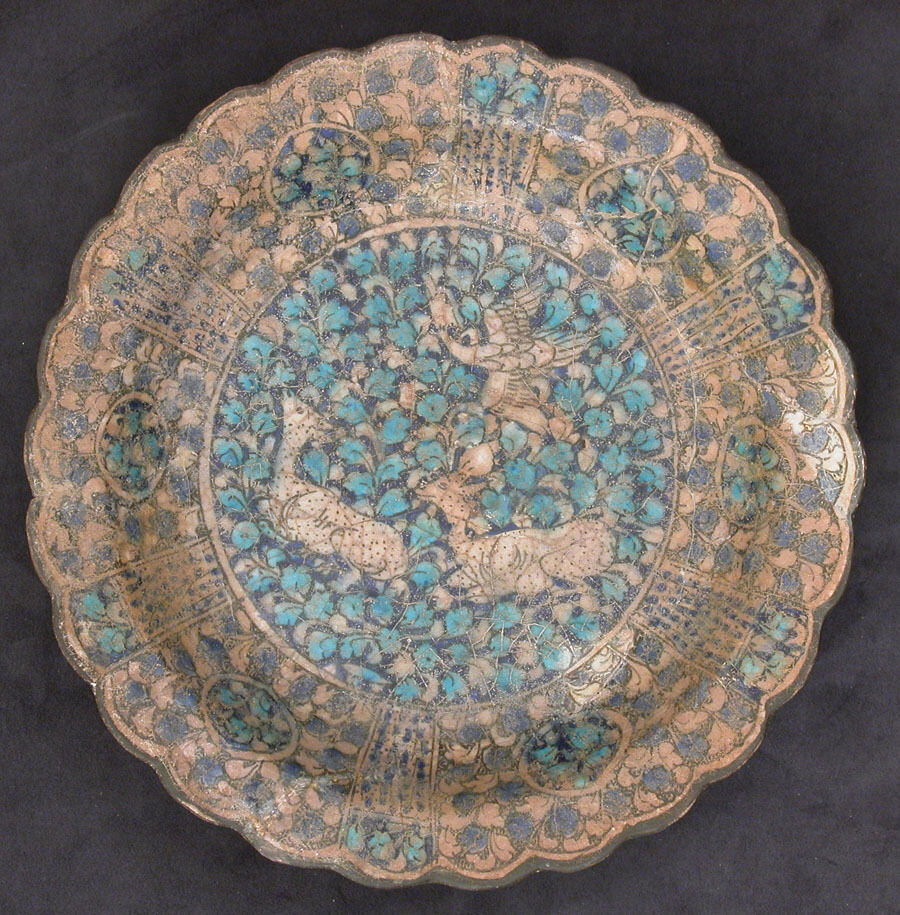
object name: dish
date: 1301-1400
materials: stonepaste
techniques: painting, underglaze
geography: iran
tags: birds